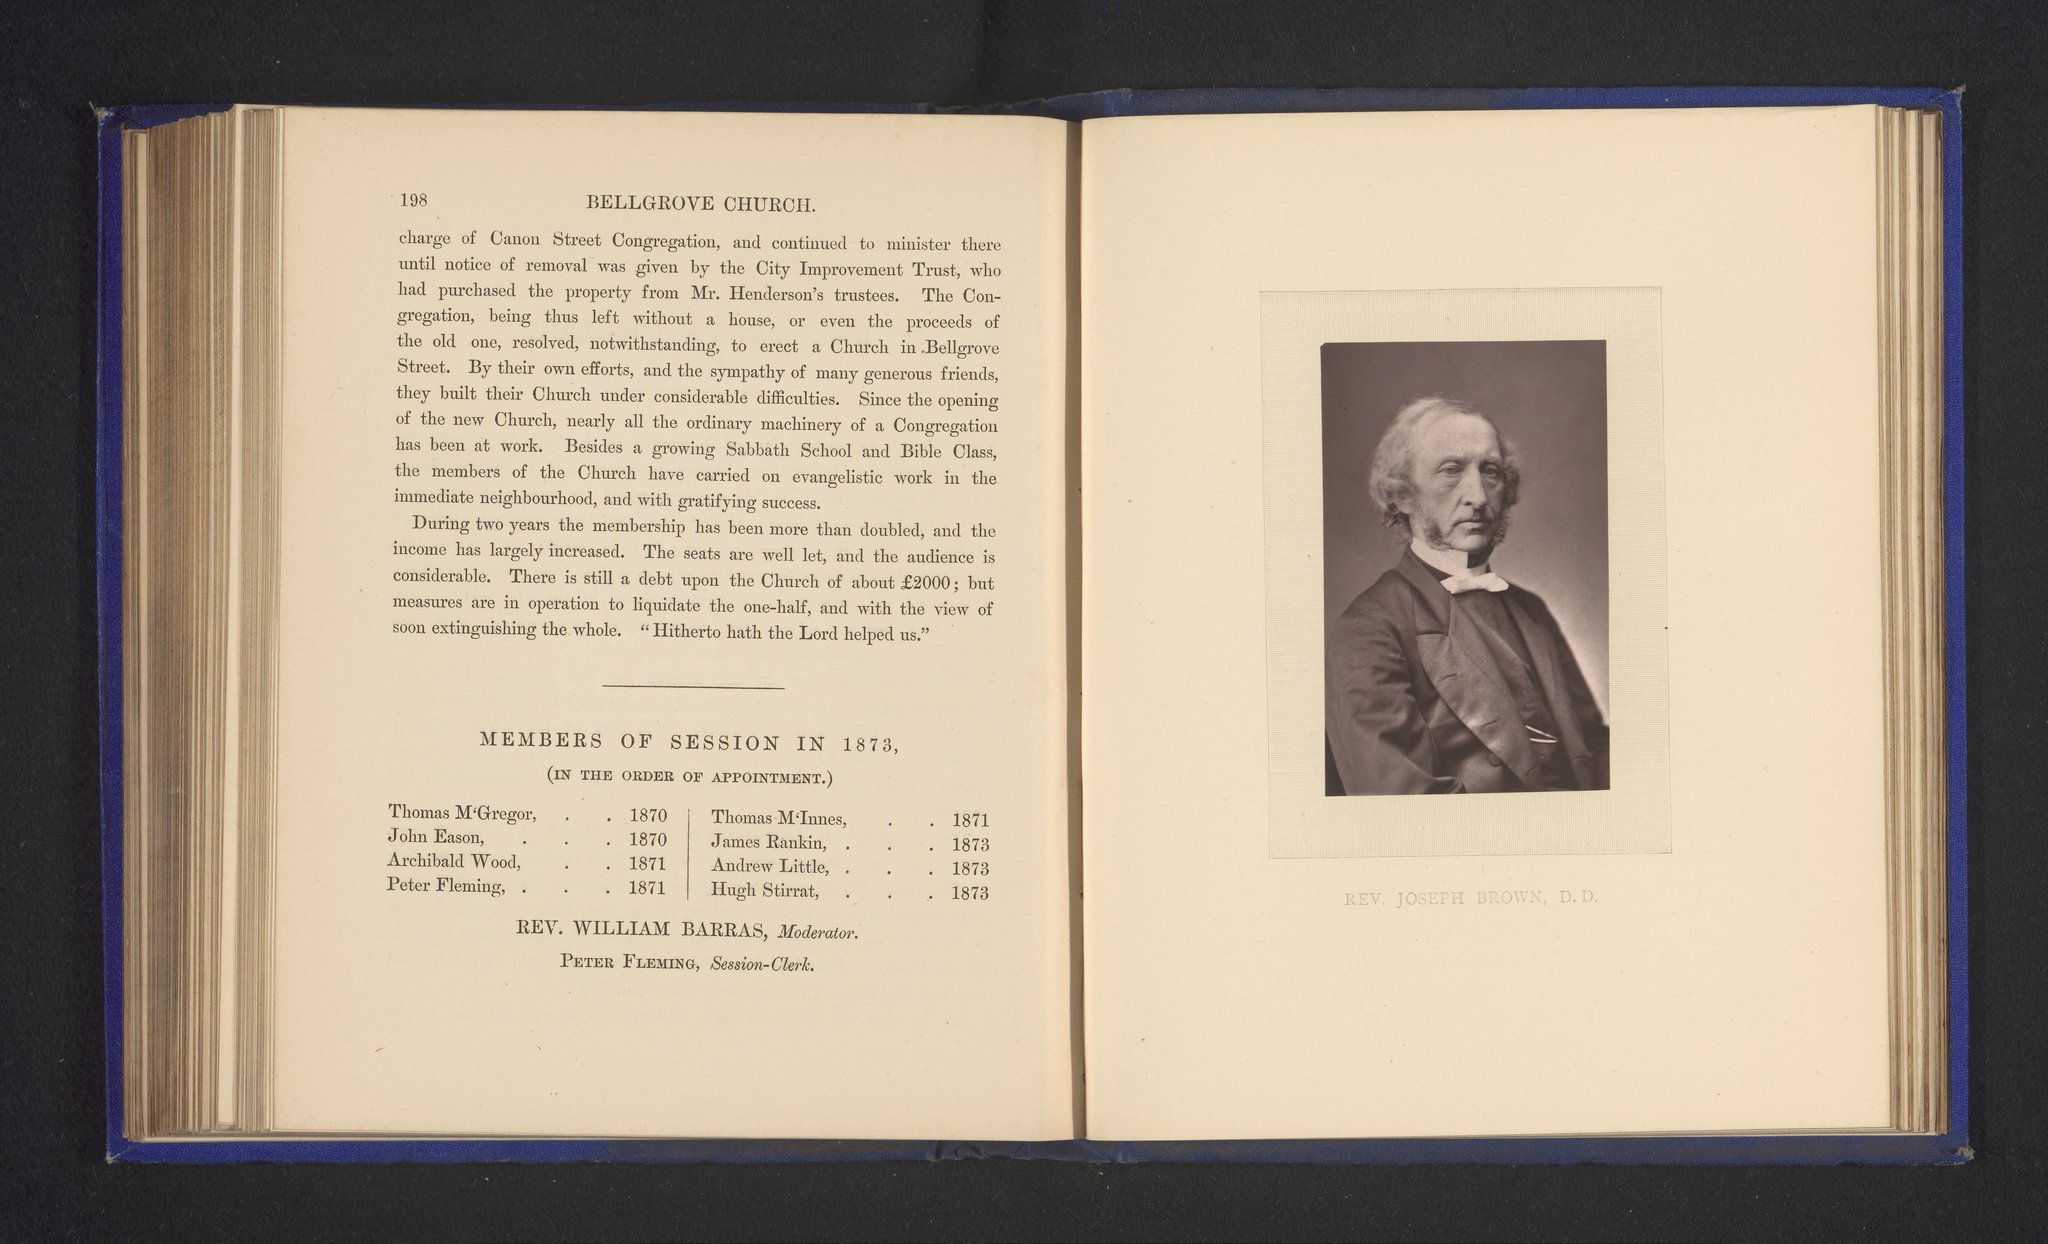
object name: photomechanical print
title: Portret van Joseph Brown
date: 1865-1875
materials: paper, photographic support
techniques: carbon print, woodburytype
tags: functionaries and dignitaries (with name) ~ protestant churches